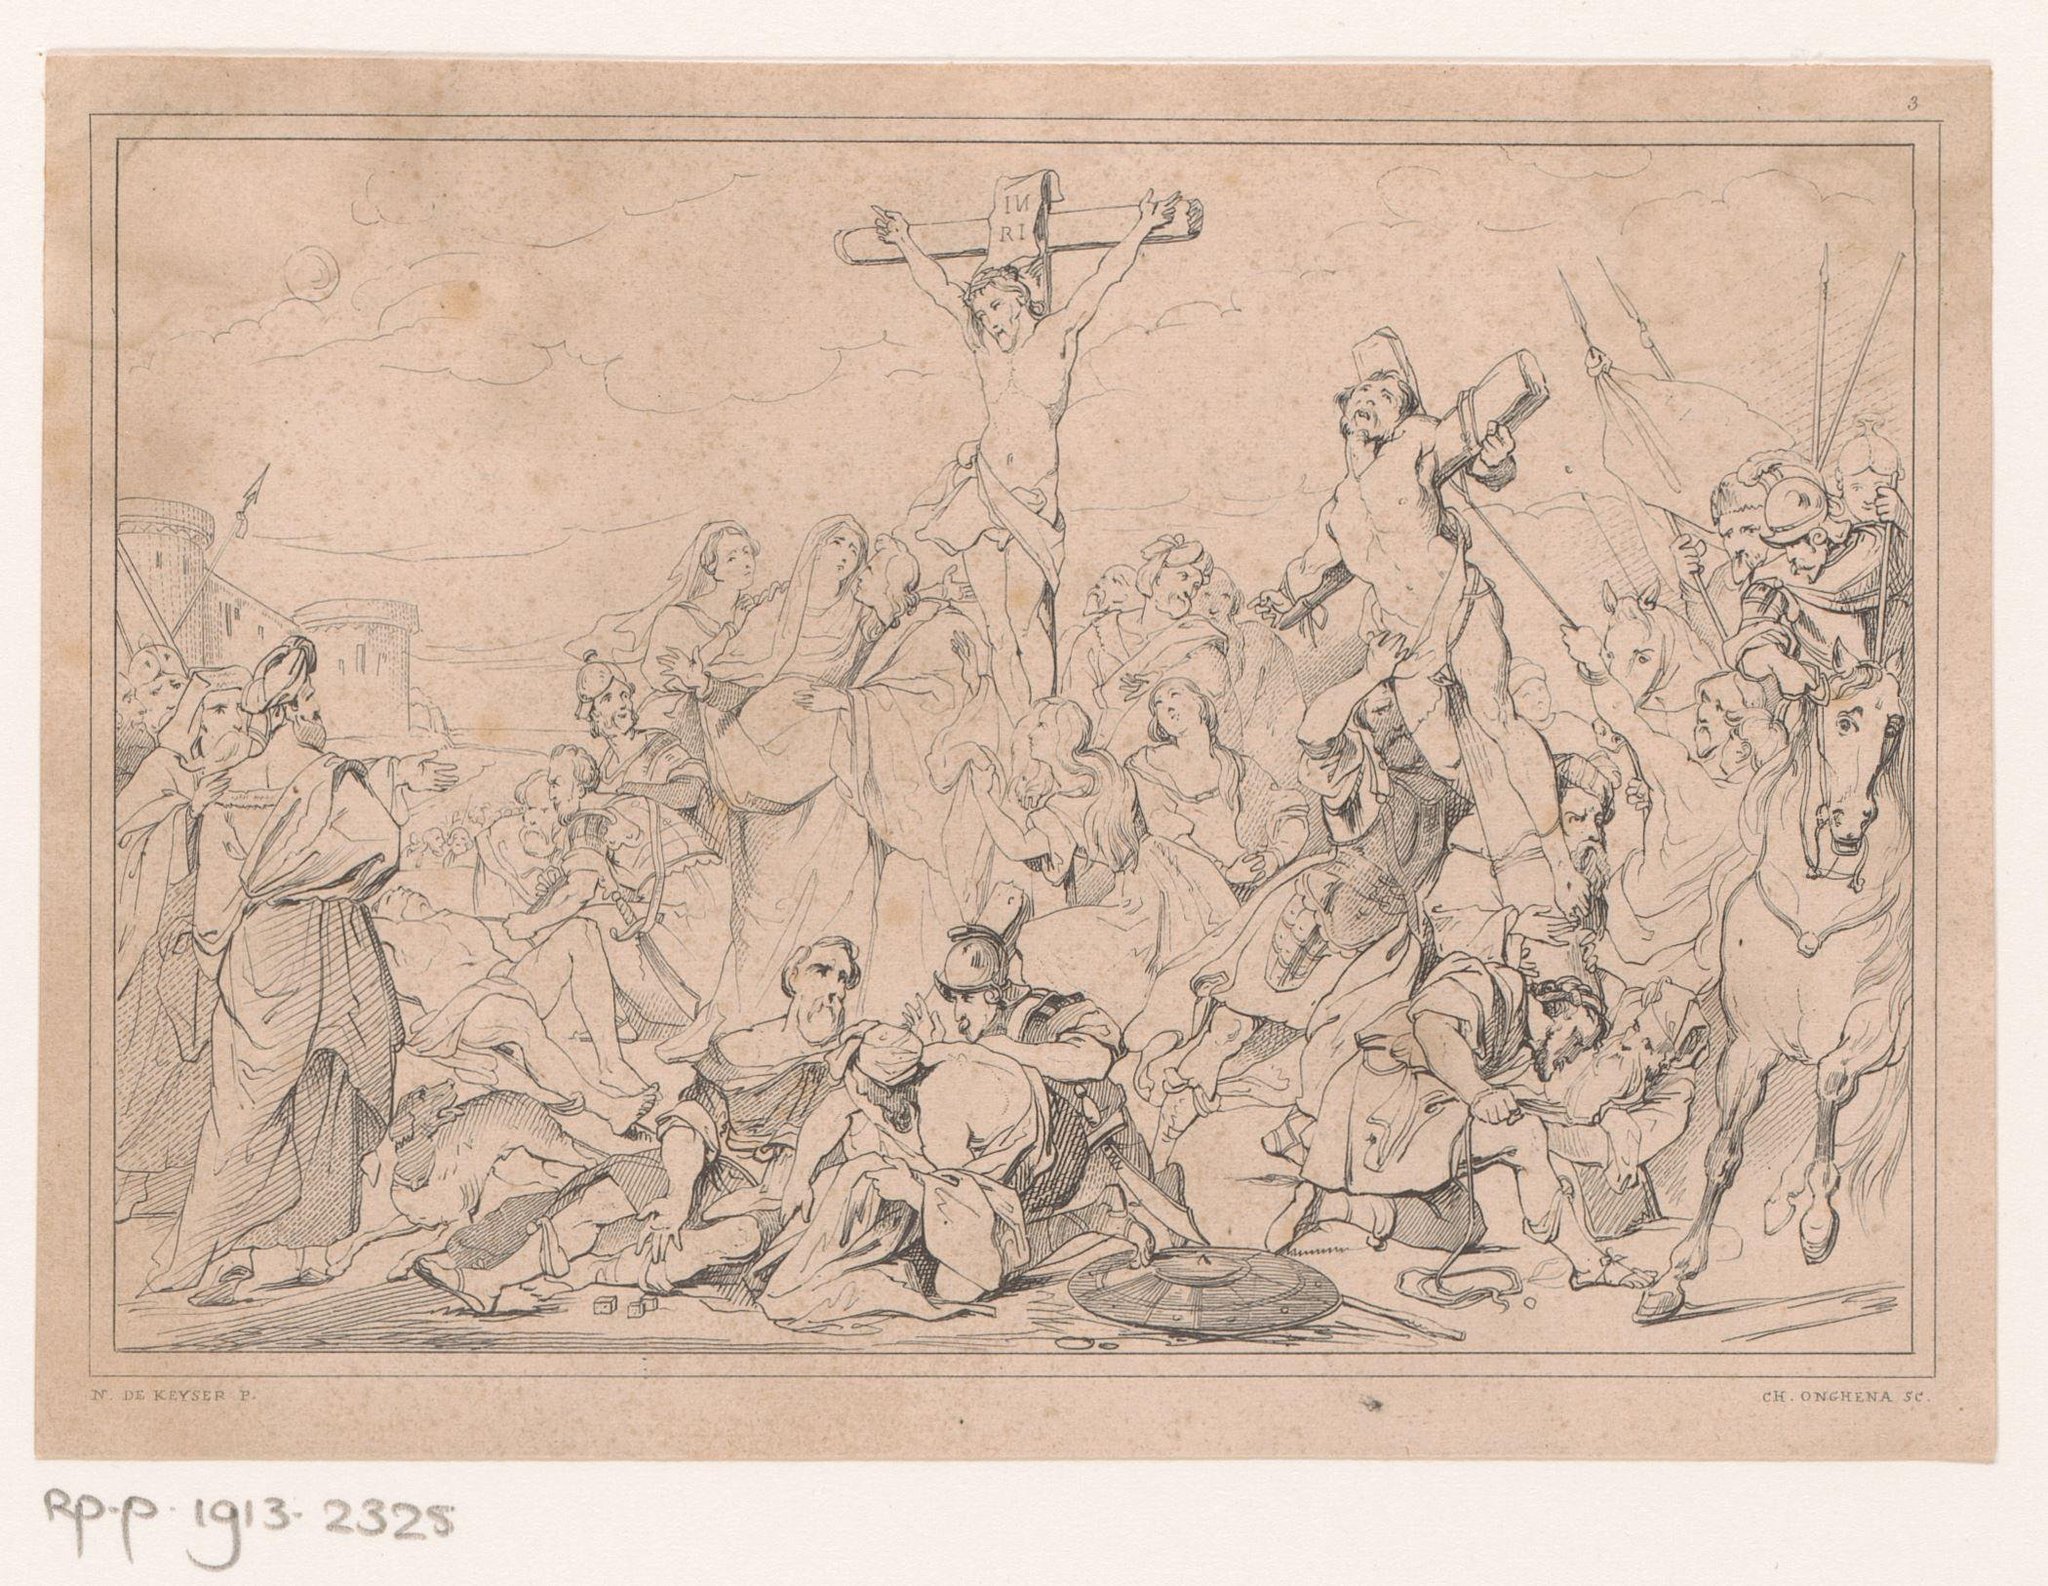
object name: print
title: Golgotha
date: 1816-1886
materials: paper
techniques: etching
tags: the crucifixion of christ: christ's death on the cross; golgotha (matthew 27:45-58; mark 15:33-45; luke 23:44-52; john 19:25-38)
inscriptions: collector's mark: Lugt 2228